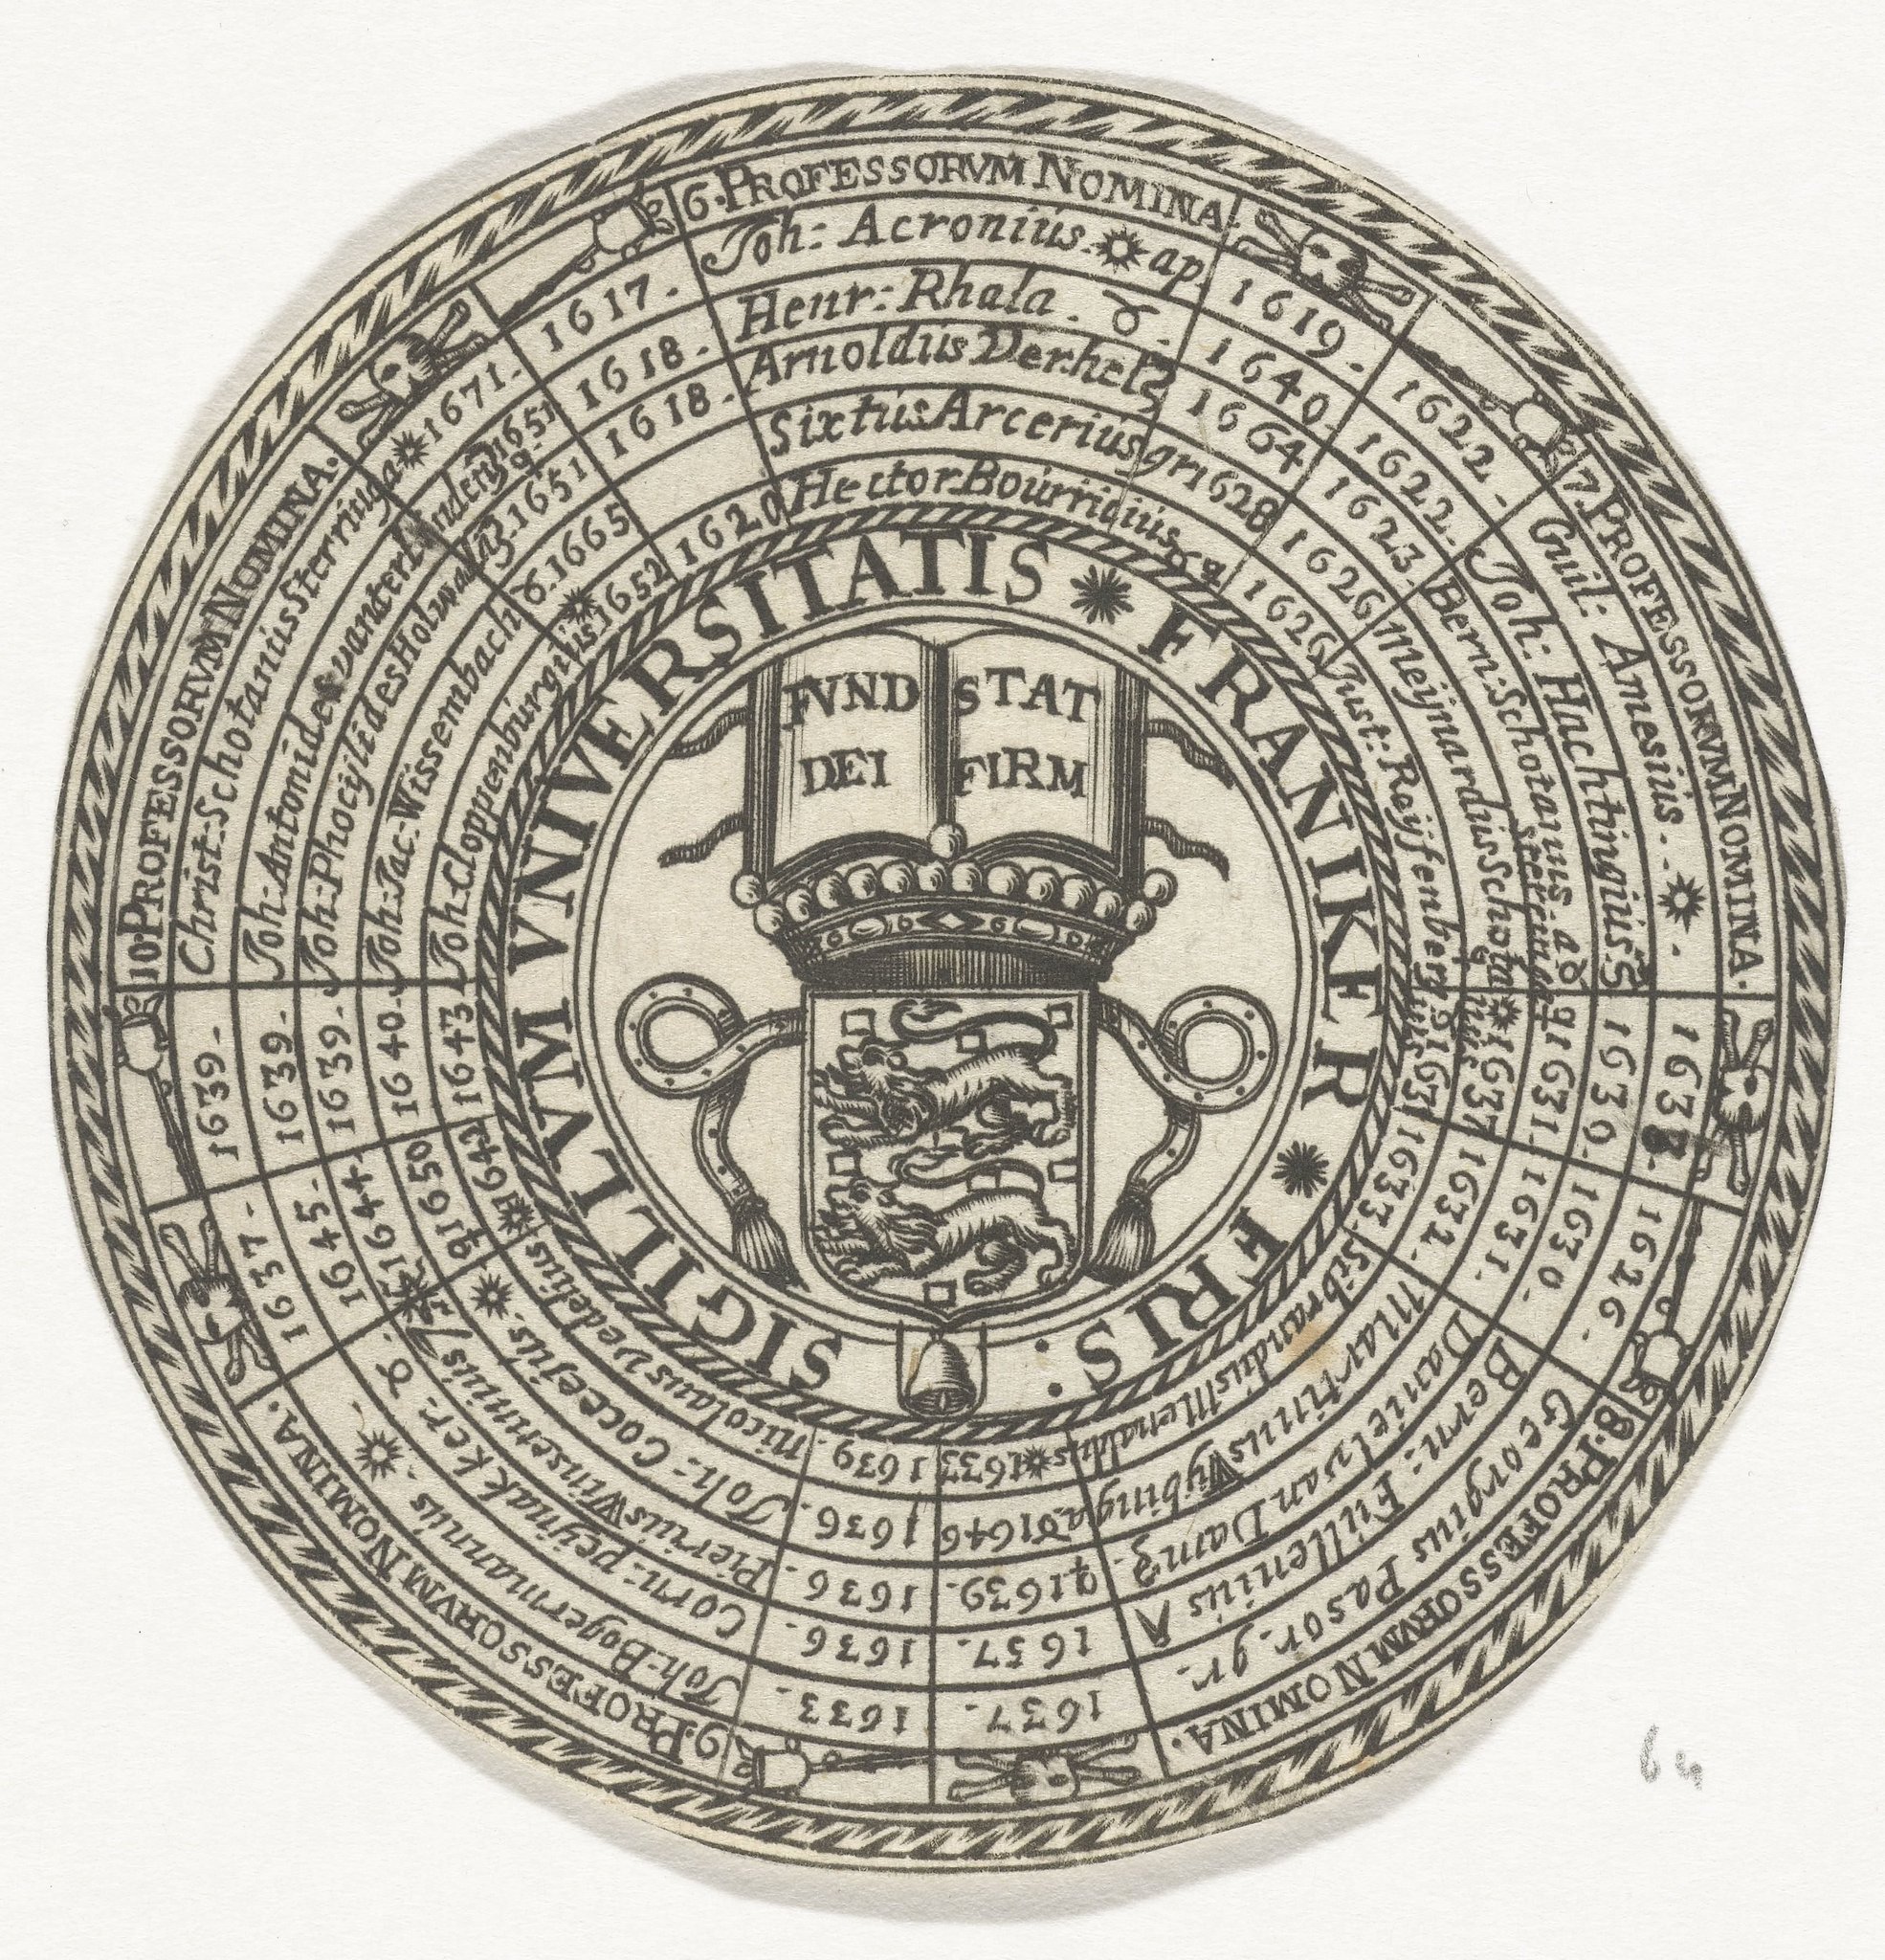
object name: print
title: Penning van de Universiteit van Franeker, met de namen van de hoogleraren en het wapen van de universiteit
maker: Anonymous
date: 1685-1720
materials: paper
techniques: engraving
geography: netherlands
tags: insignia, seal ~ university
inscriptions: number: ‘68’